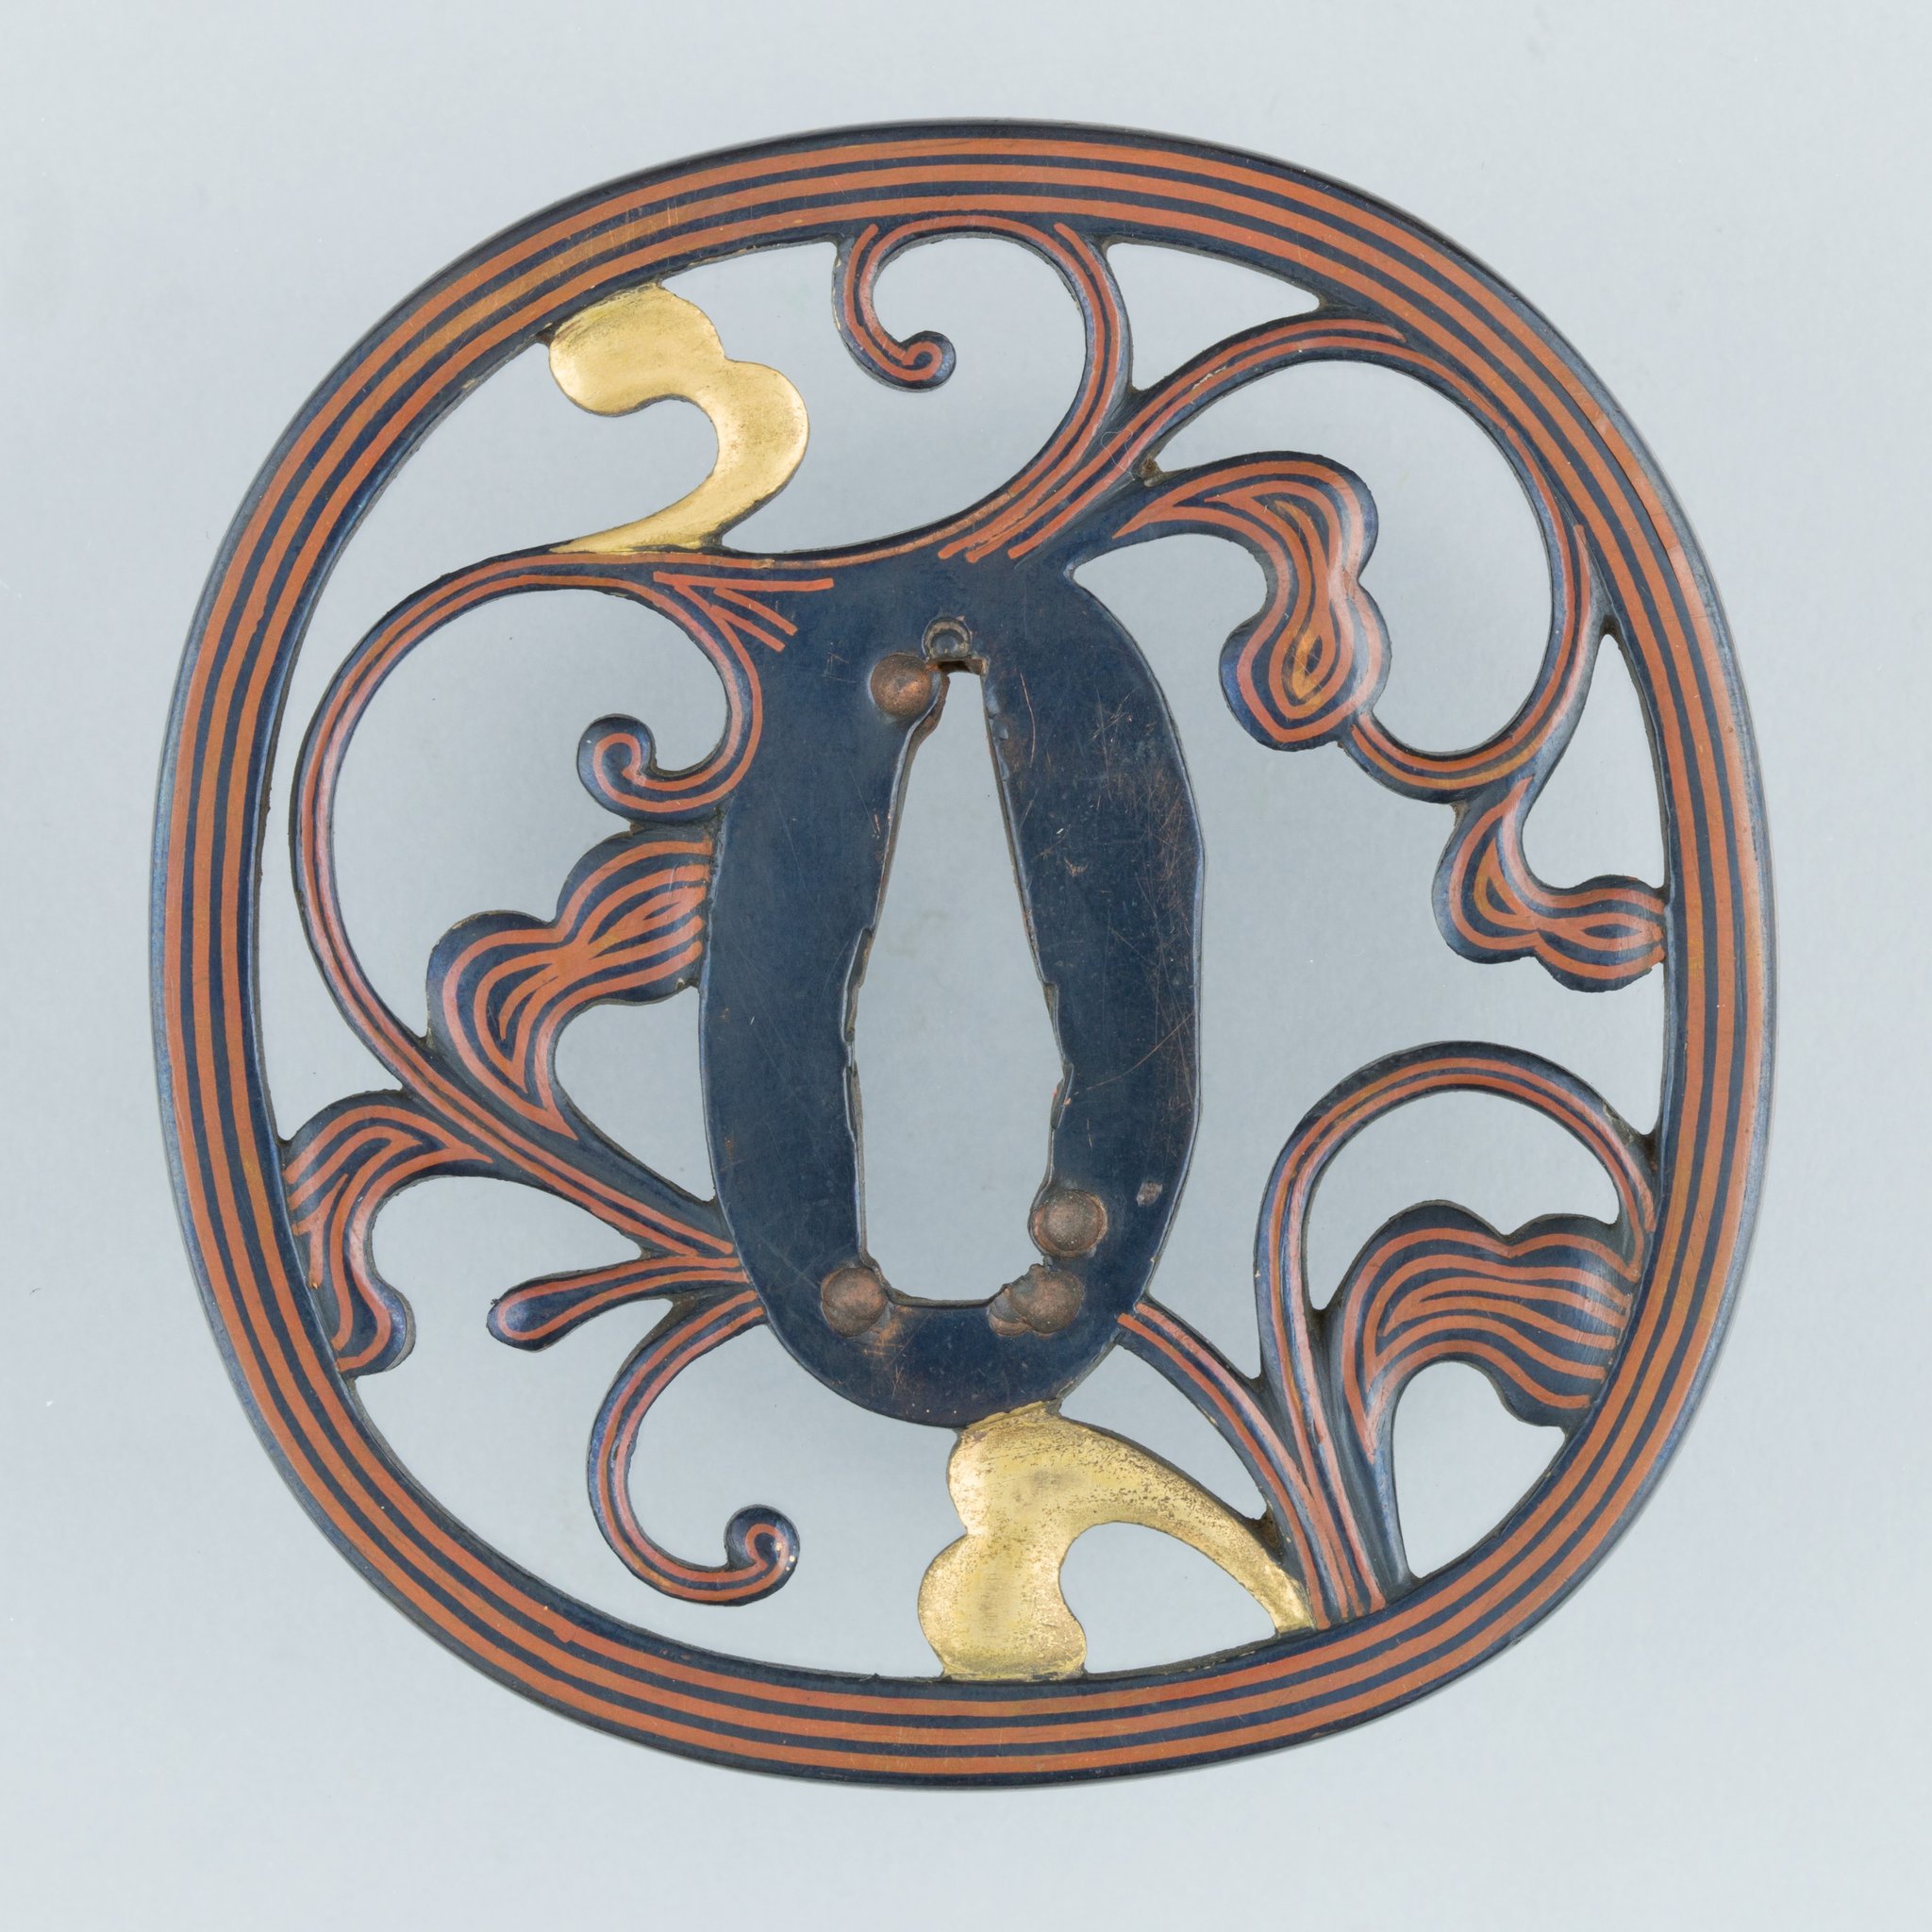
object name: sword guard tsuba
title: Sword Guard (Tsuba)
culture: japanese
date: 1615-1868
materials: copper, gold alloy, gold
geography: japan